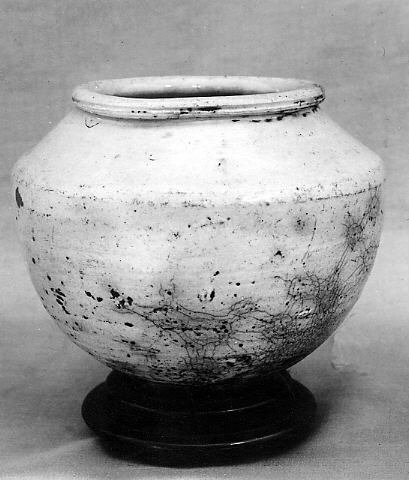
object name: jar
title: Jar with Ivory Lid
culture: japanese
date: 1701-1800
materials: clay, glaze